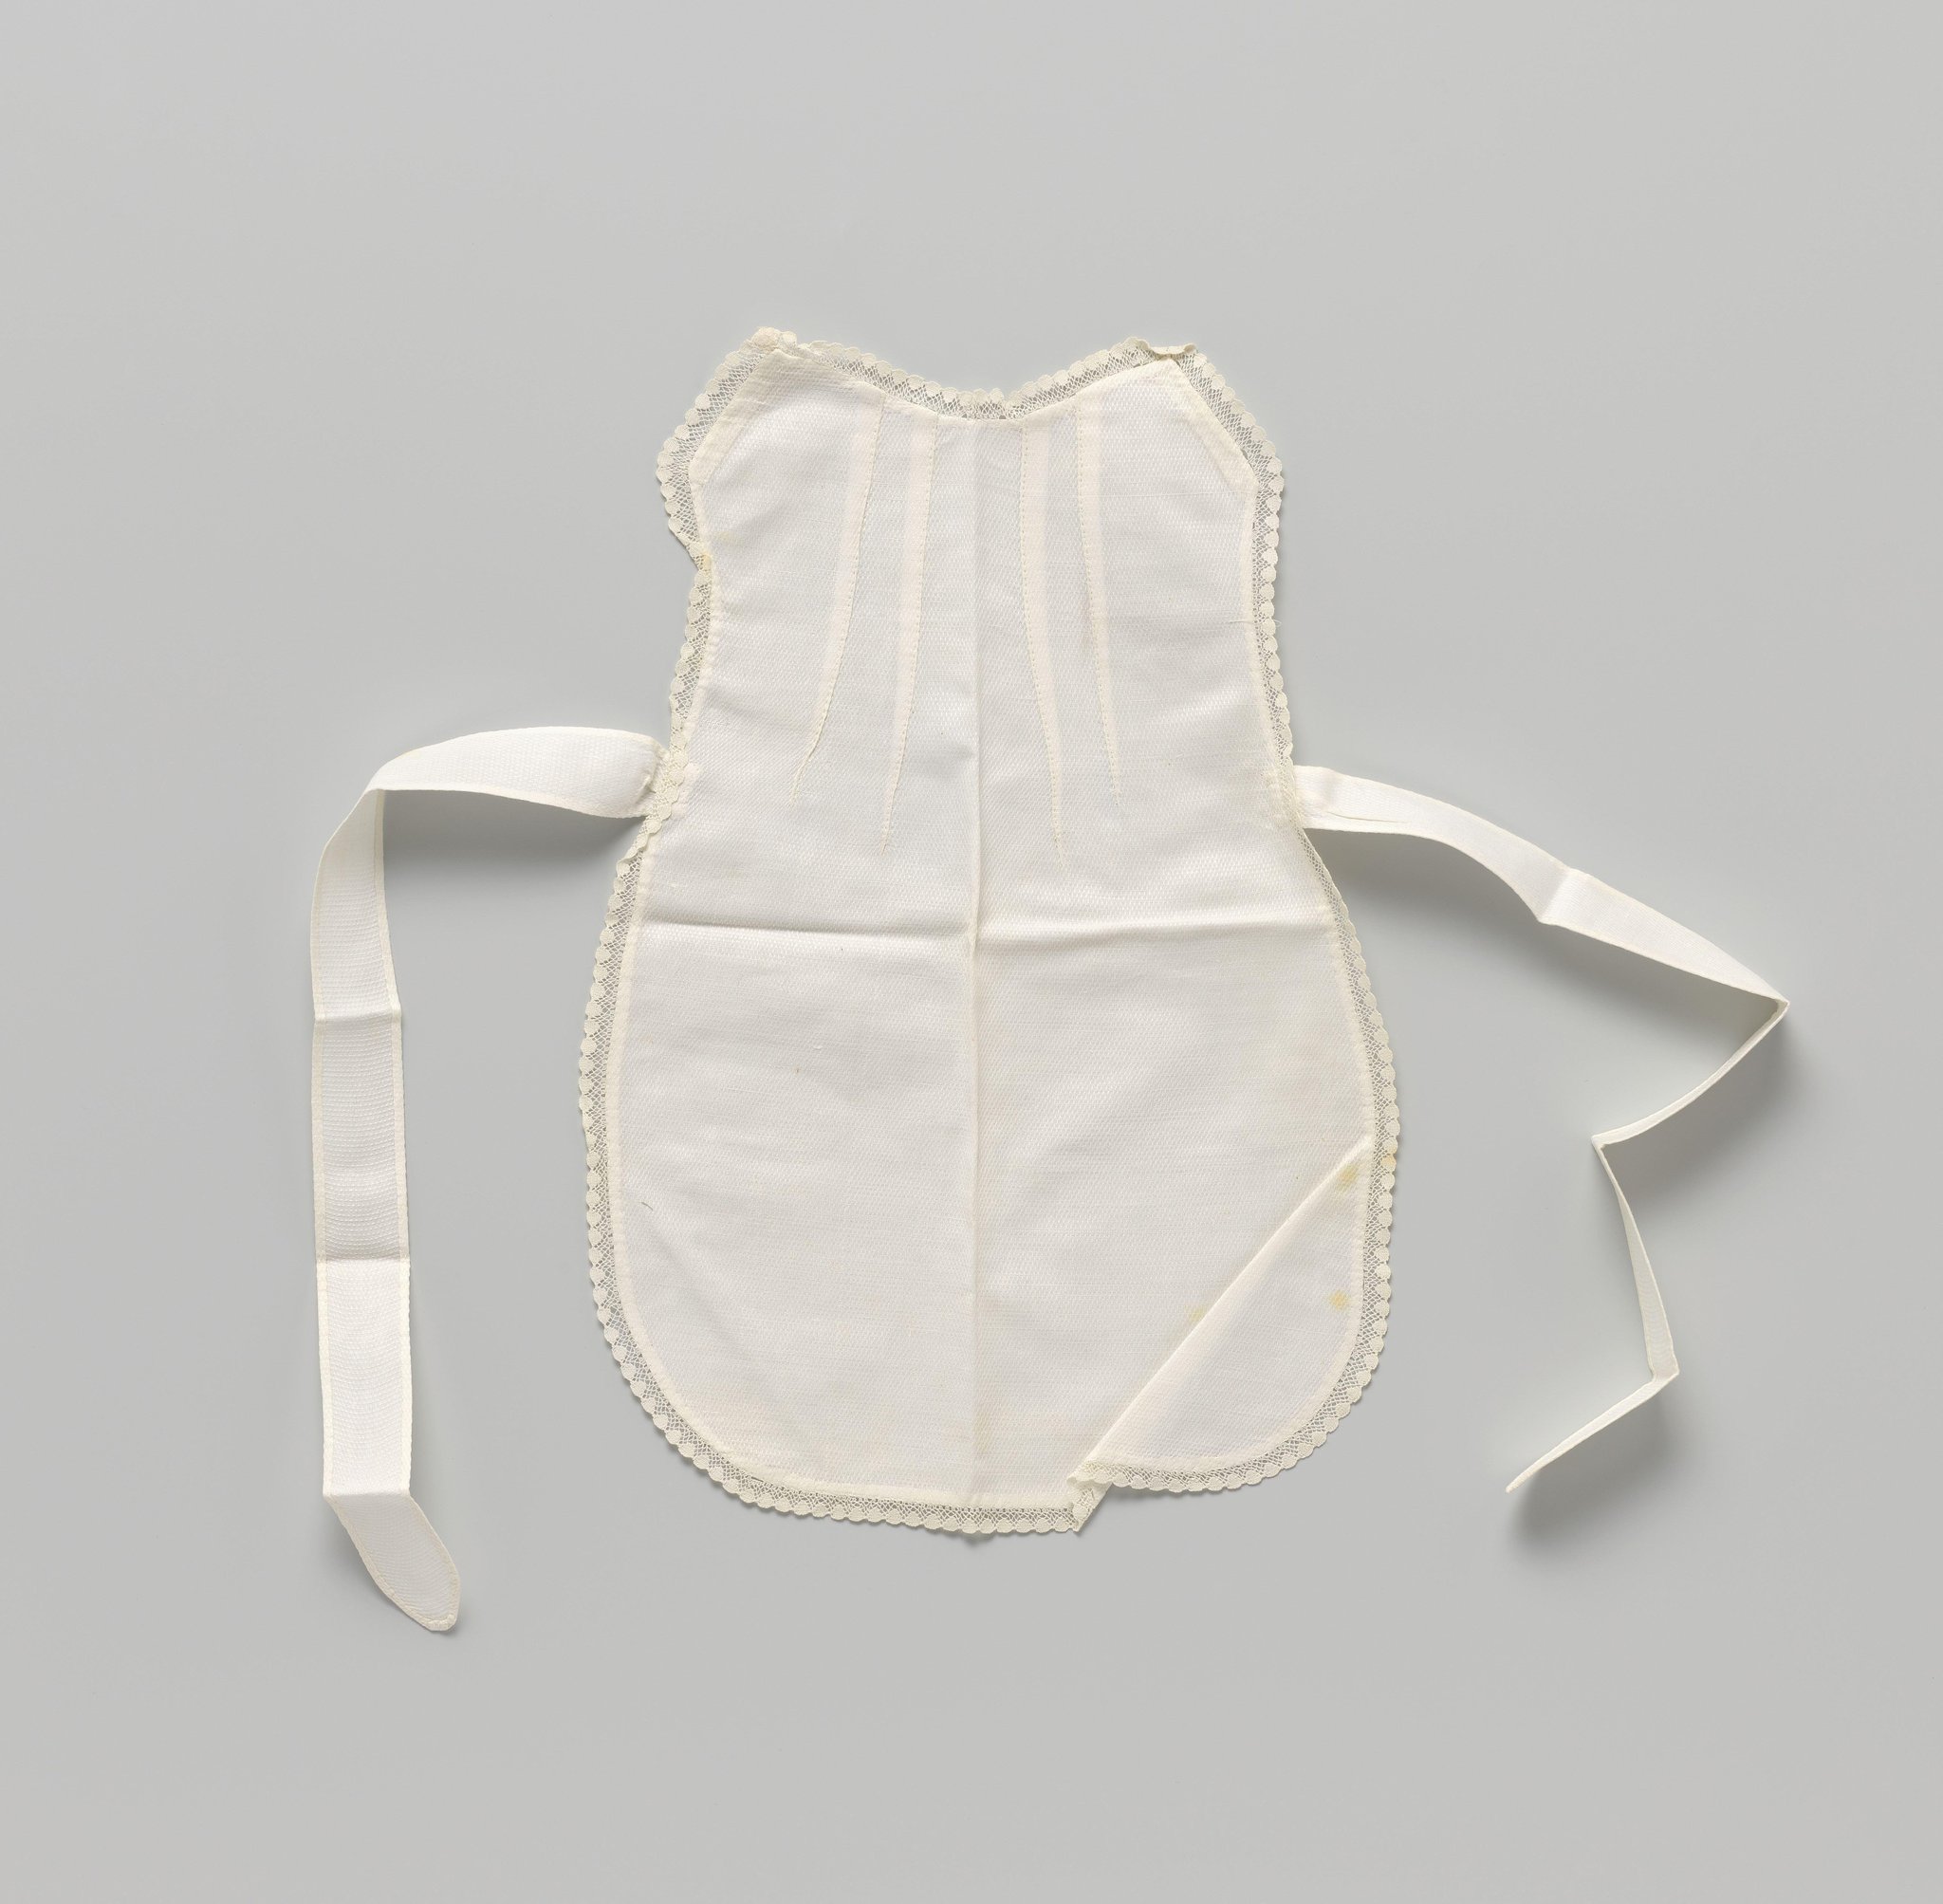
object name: apron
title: Wit schort afgezet met rand kant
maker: Anonymous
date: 1850-1920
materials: textile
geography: netherlands